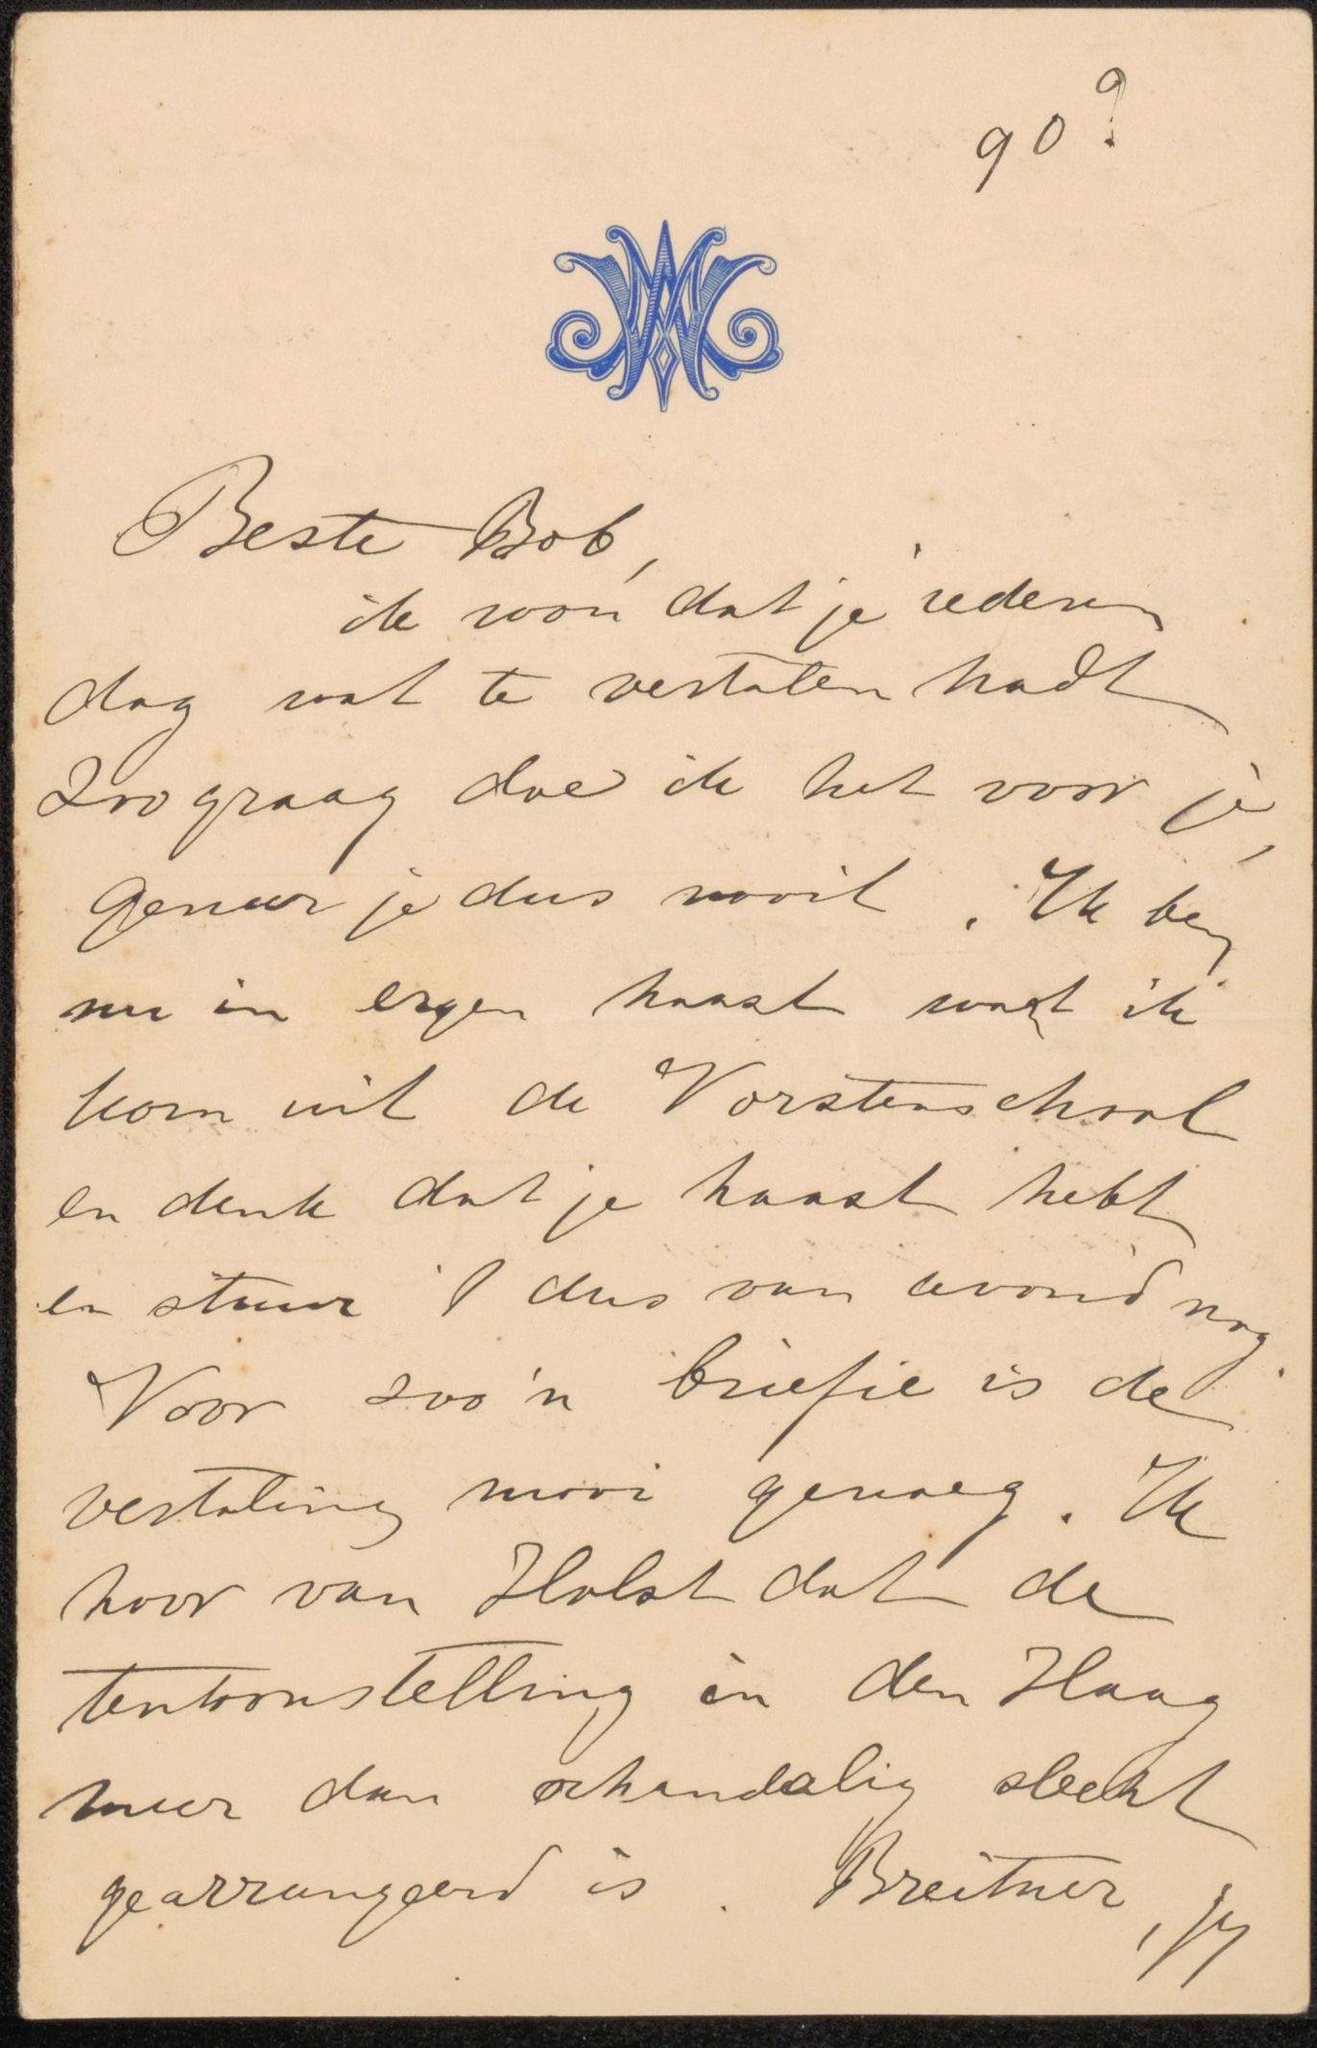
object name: letter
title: Brief aan Jan Veth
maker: wally moes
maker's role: draughtsman, print maker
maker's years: 1856-1918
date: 1874-1918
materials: ink, paper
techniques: pen, writing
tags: rotterdam, george hendrik breitner, dordrecht, designer, jan veth, the hague, willy martens, maurits van der valk, leiden, painter, print maker, draughtsman, floris verster, richard nicolaüs roland holst, exhibition ~ art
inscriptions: collector's mark: ‘RPK’, monogram: ‘WM’, watermark